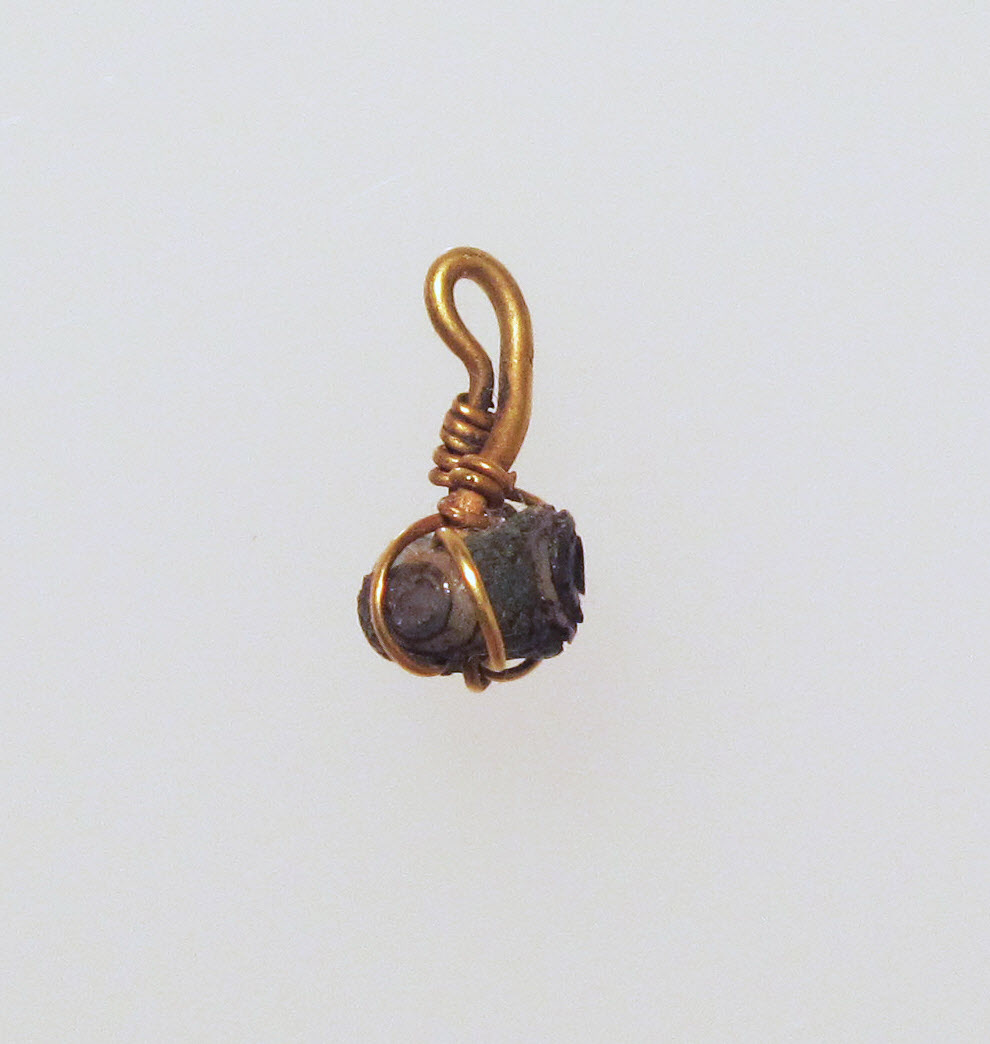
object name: pendant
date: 7000 BCE-330 CE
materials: gold